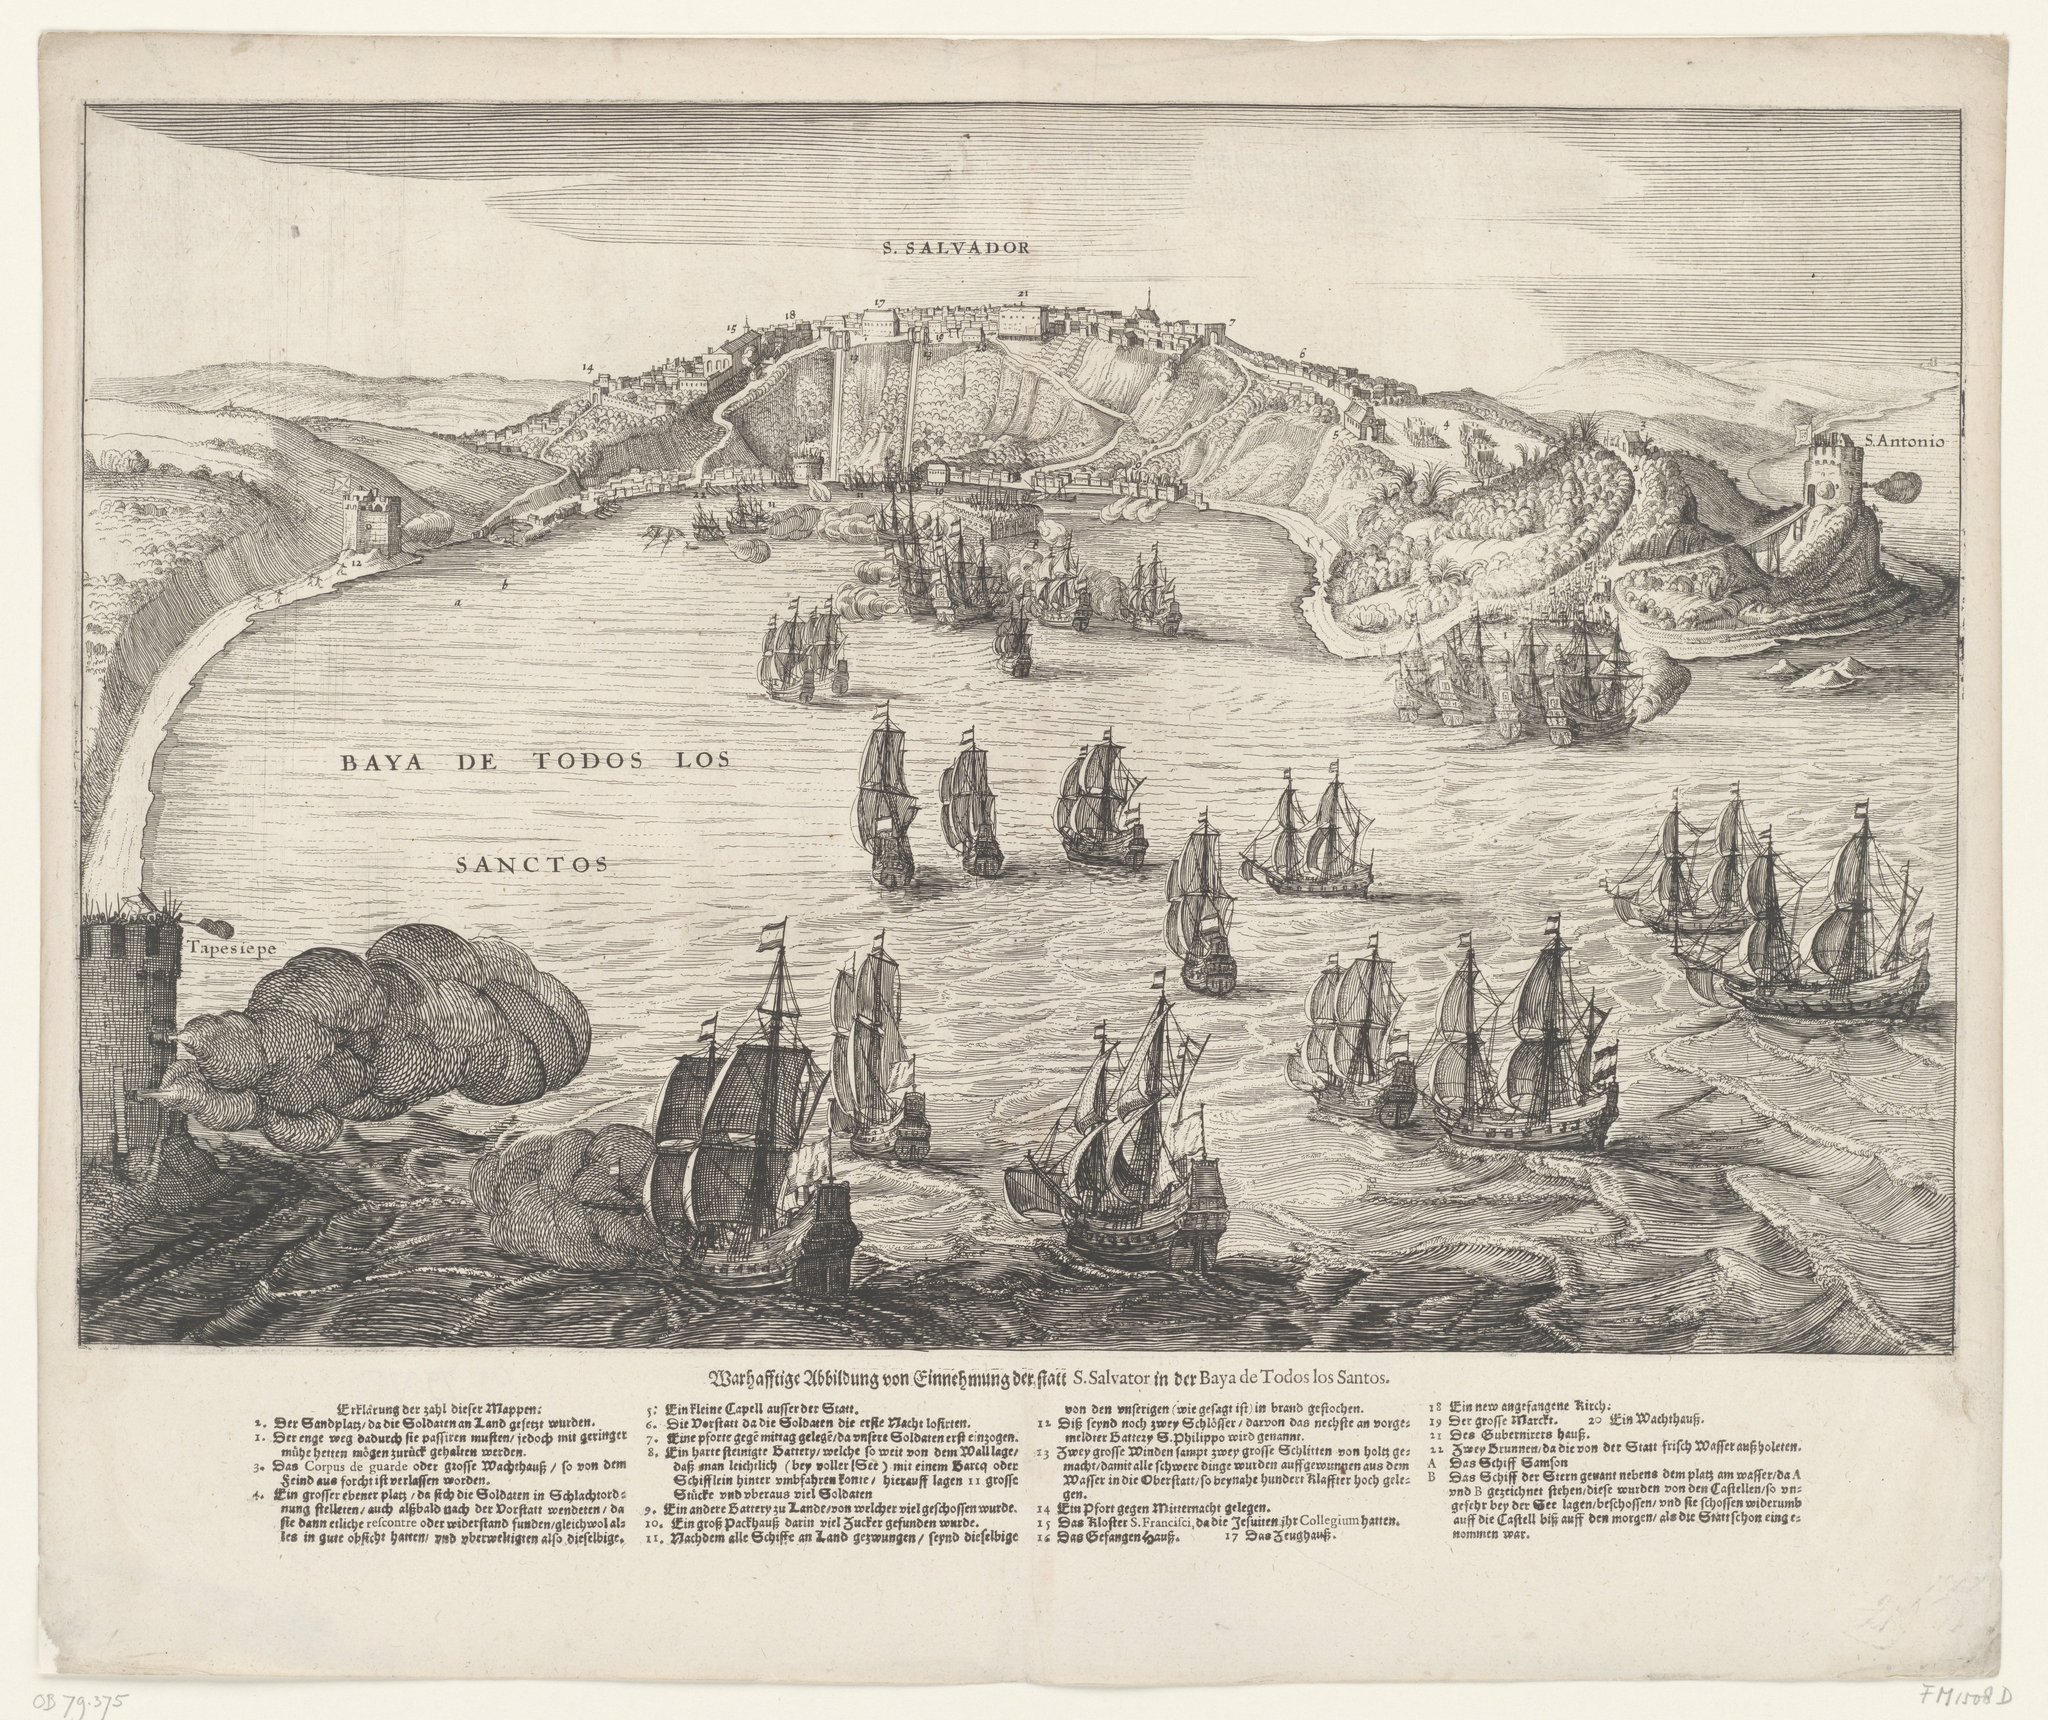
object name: print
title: Verovering van San Salvador in Brazilië door admiraal Jacob Willekes, 1624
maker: Anonymous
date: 1624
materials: paper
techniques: etching, letterpress printing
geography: germany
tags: battle (+ naval force), capture of city (after the siege)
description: De verovering van San Salvador in Brazilië door admiraal Jacob Willekes voor de WIC, 10 mei 1624. Gezicht op de stad en forten aan de ingang van de baai van waaruit de Hollandse vloot beschoten wordt. Gedrukt onder de plaat de legenda 1-22 en A-B in 4 kolommen in het Duits.